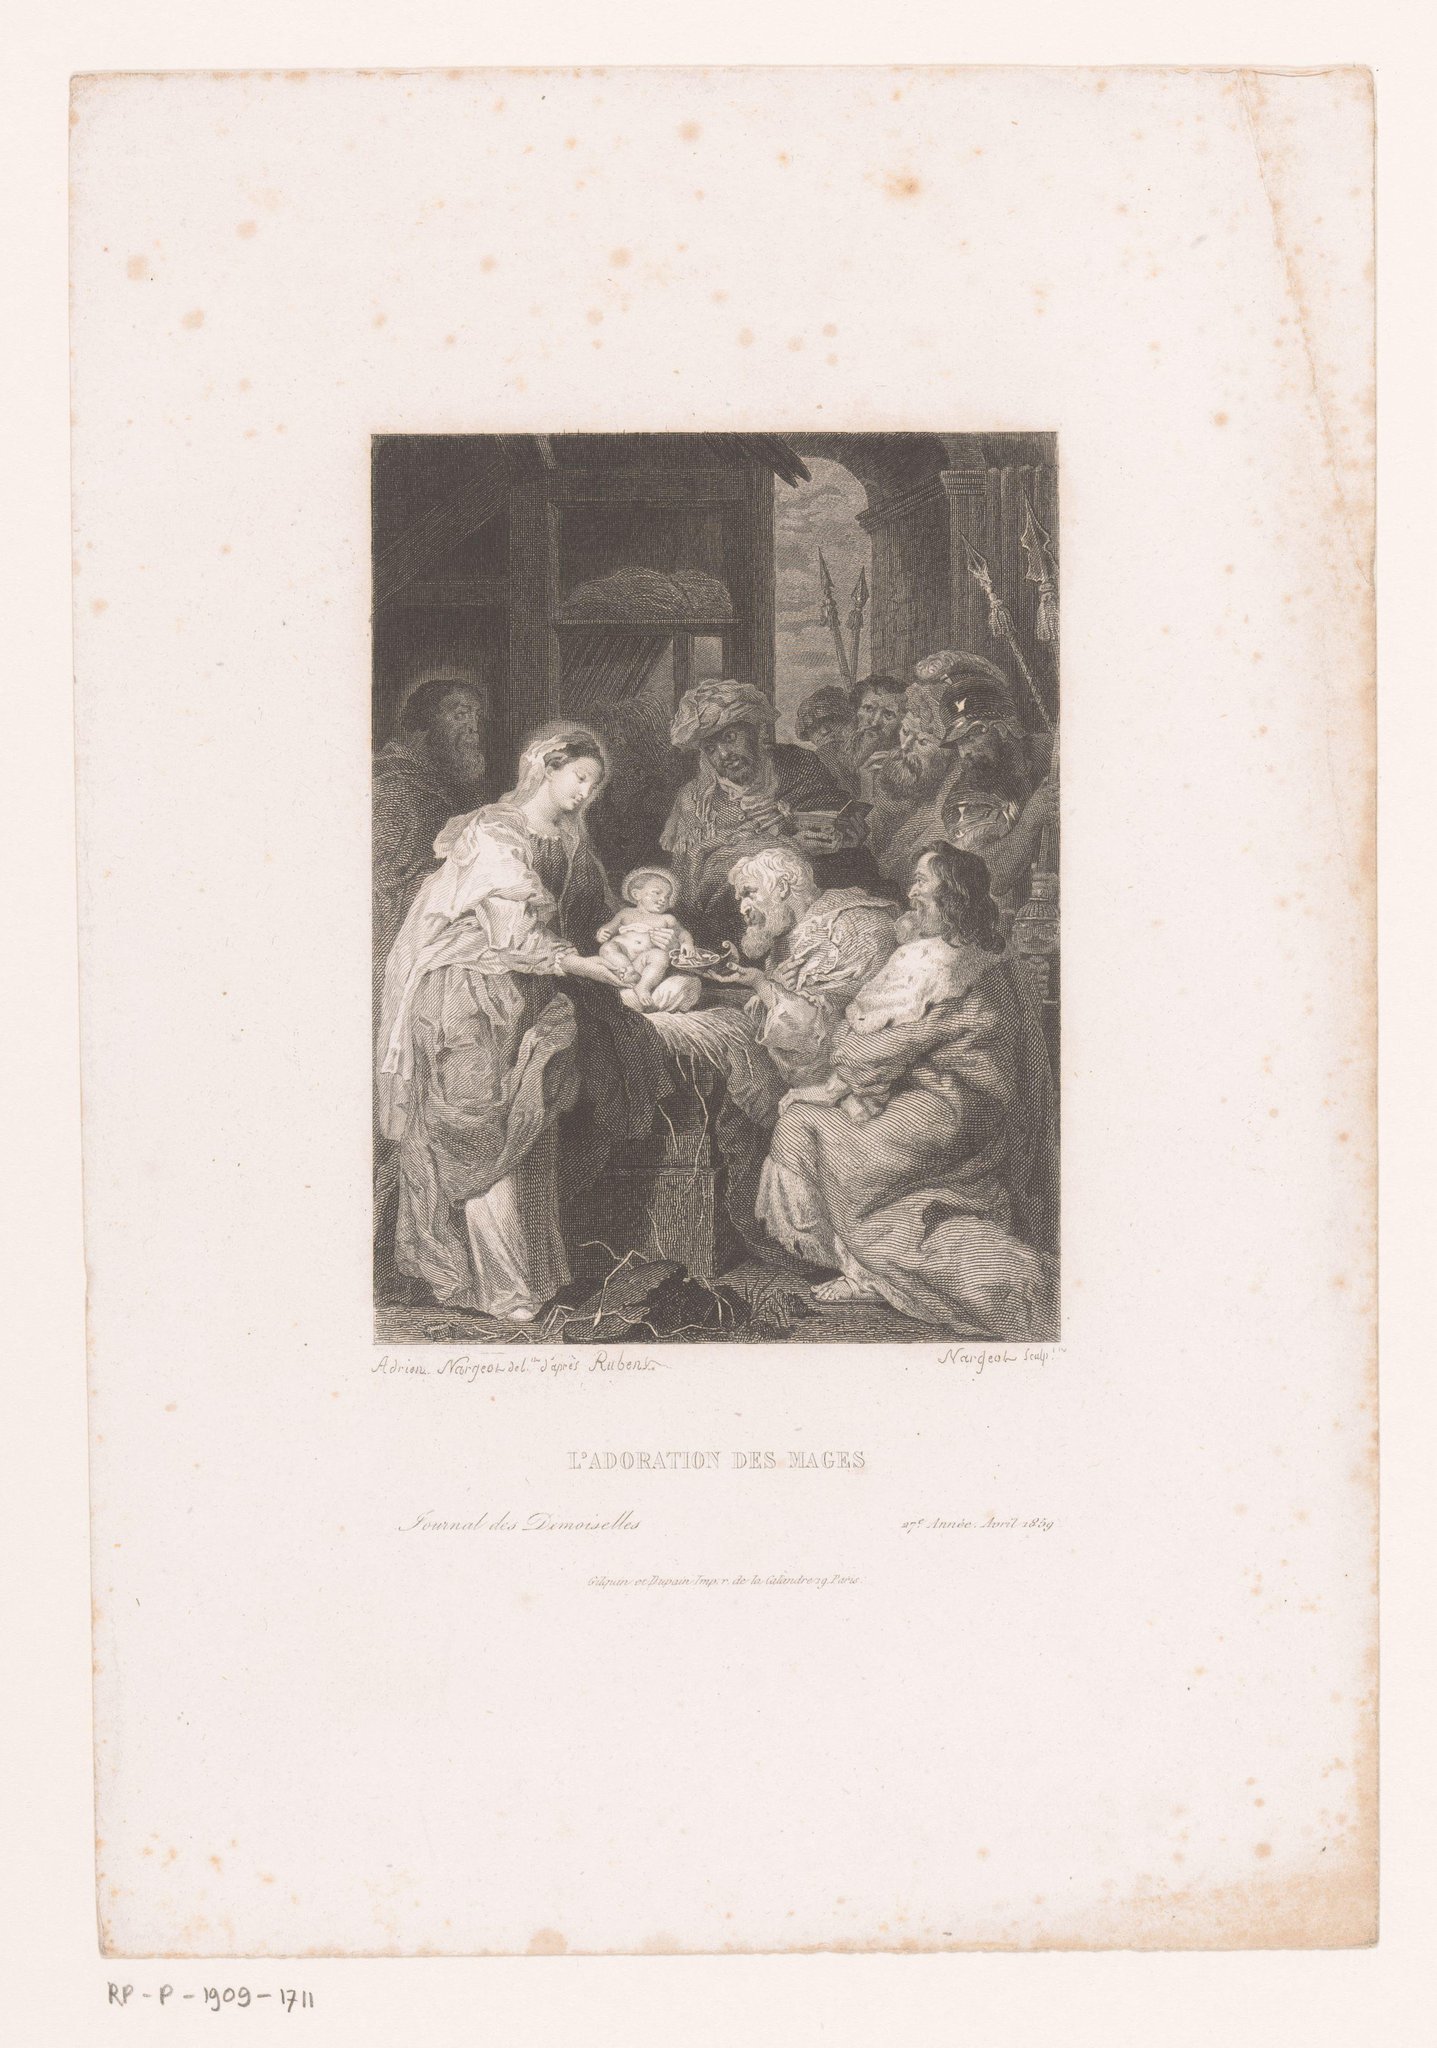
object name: print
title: L'Adoration des Mages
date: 1859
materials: paper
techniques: etching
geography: paris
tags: adoration of the kings: the wise men present their gifts to the christ-child (gold, frankincense and myrrh)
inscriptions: collector's mark: Lugt 2228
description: Gepubliceerd in 'Journal des Desmoiselles', april 1859, jaargang 27.